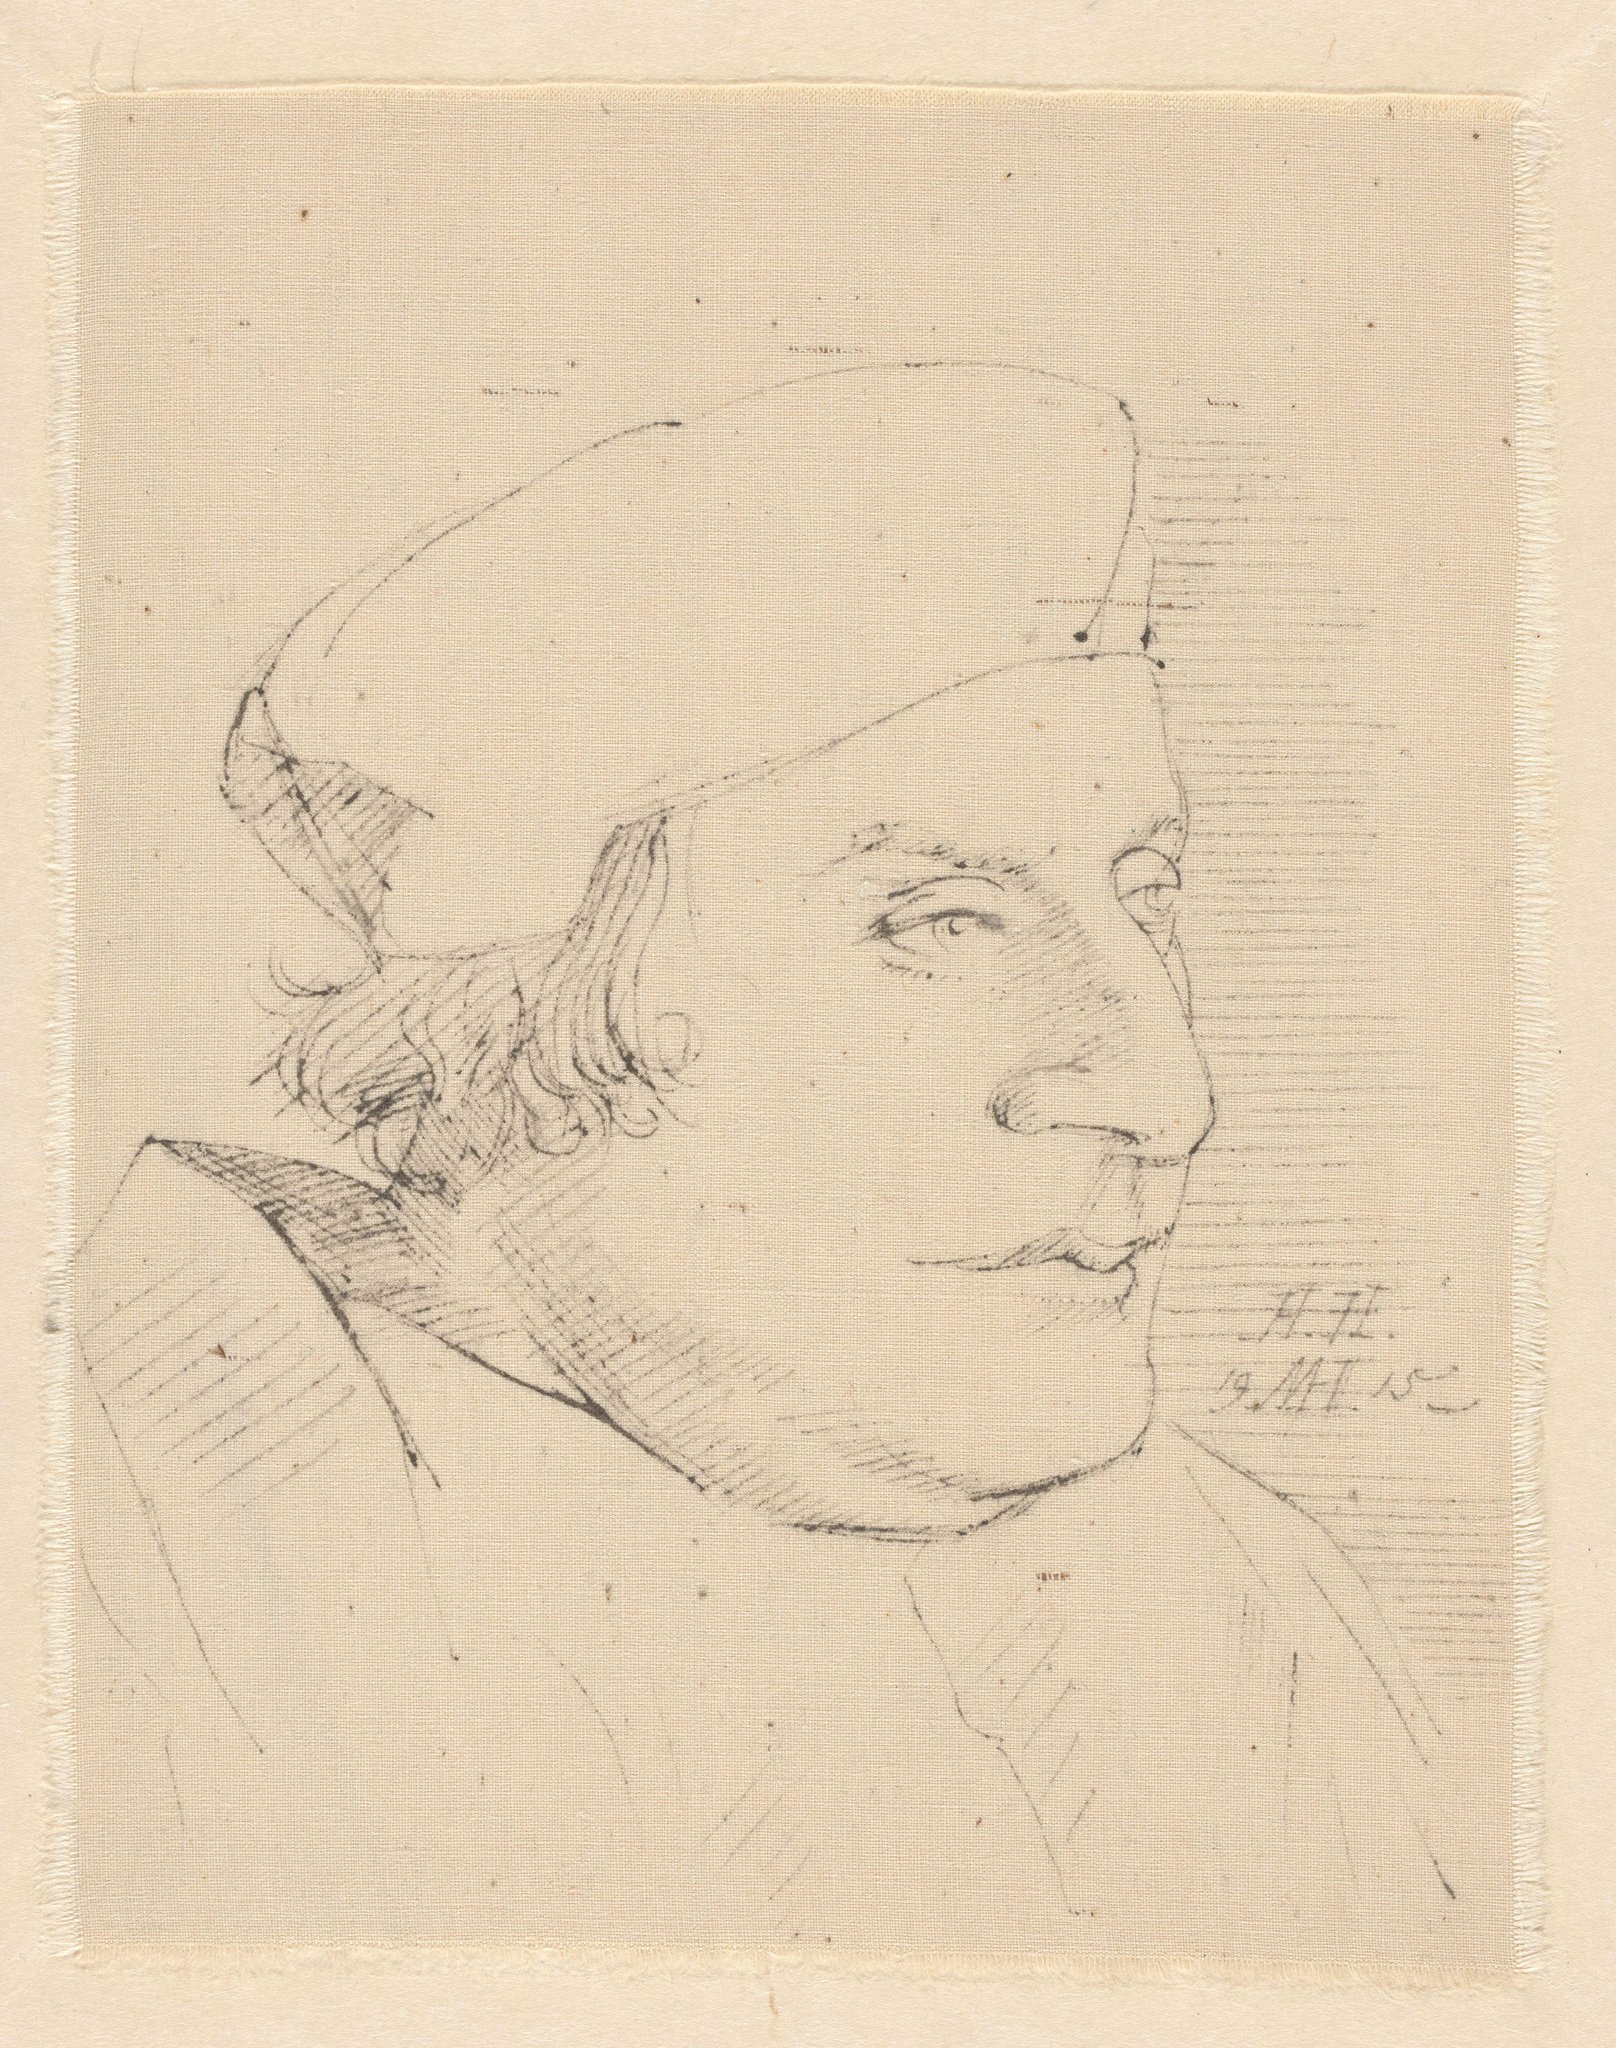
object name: drawing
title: Portret van een man met hoed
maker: marius holleman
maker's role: draughtsman, print maker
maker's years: 1878-1926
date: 1915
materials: ink, linen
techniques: pen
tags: anonymous historical person portrayed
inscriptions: inscription: ‘H.H.’